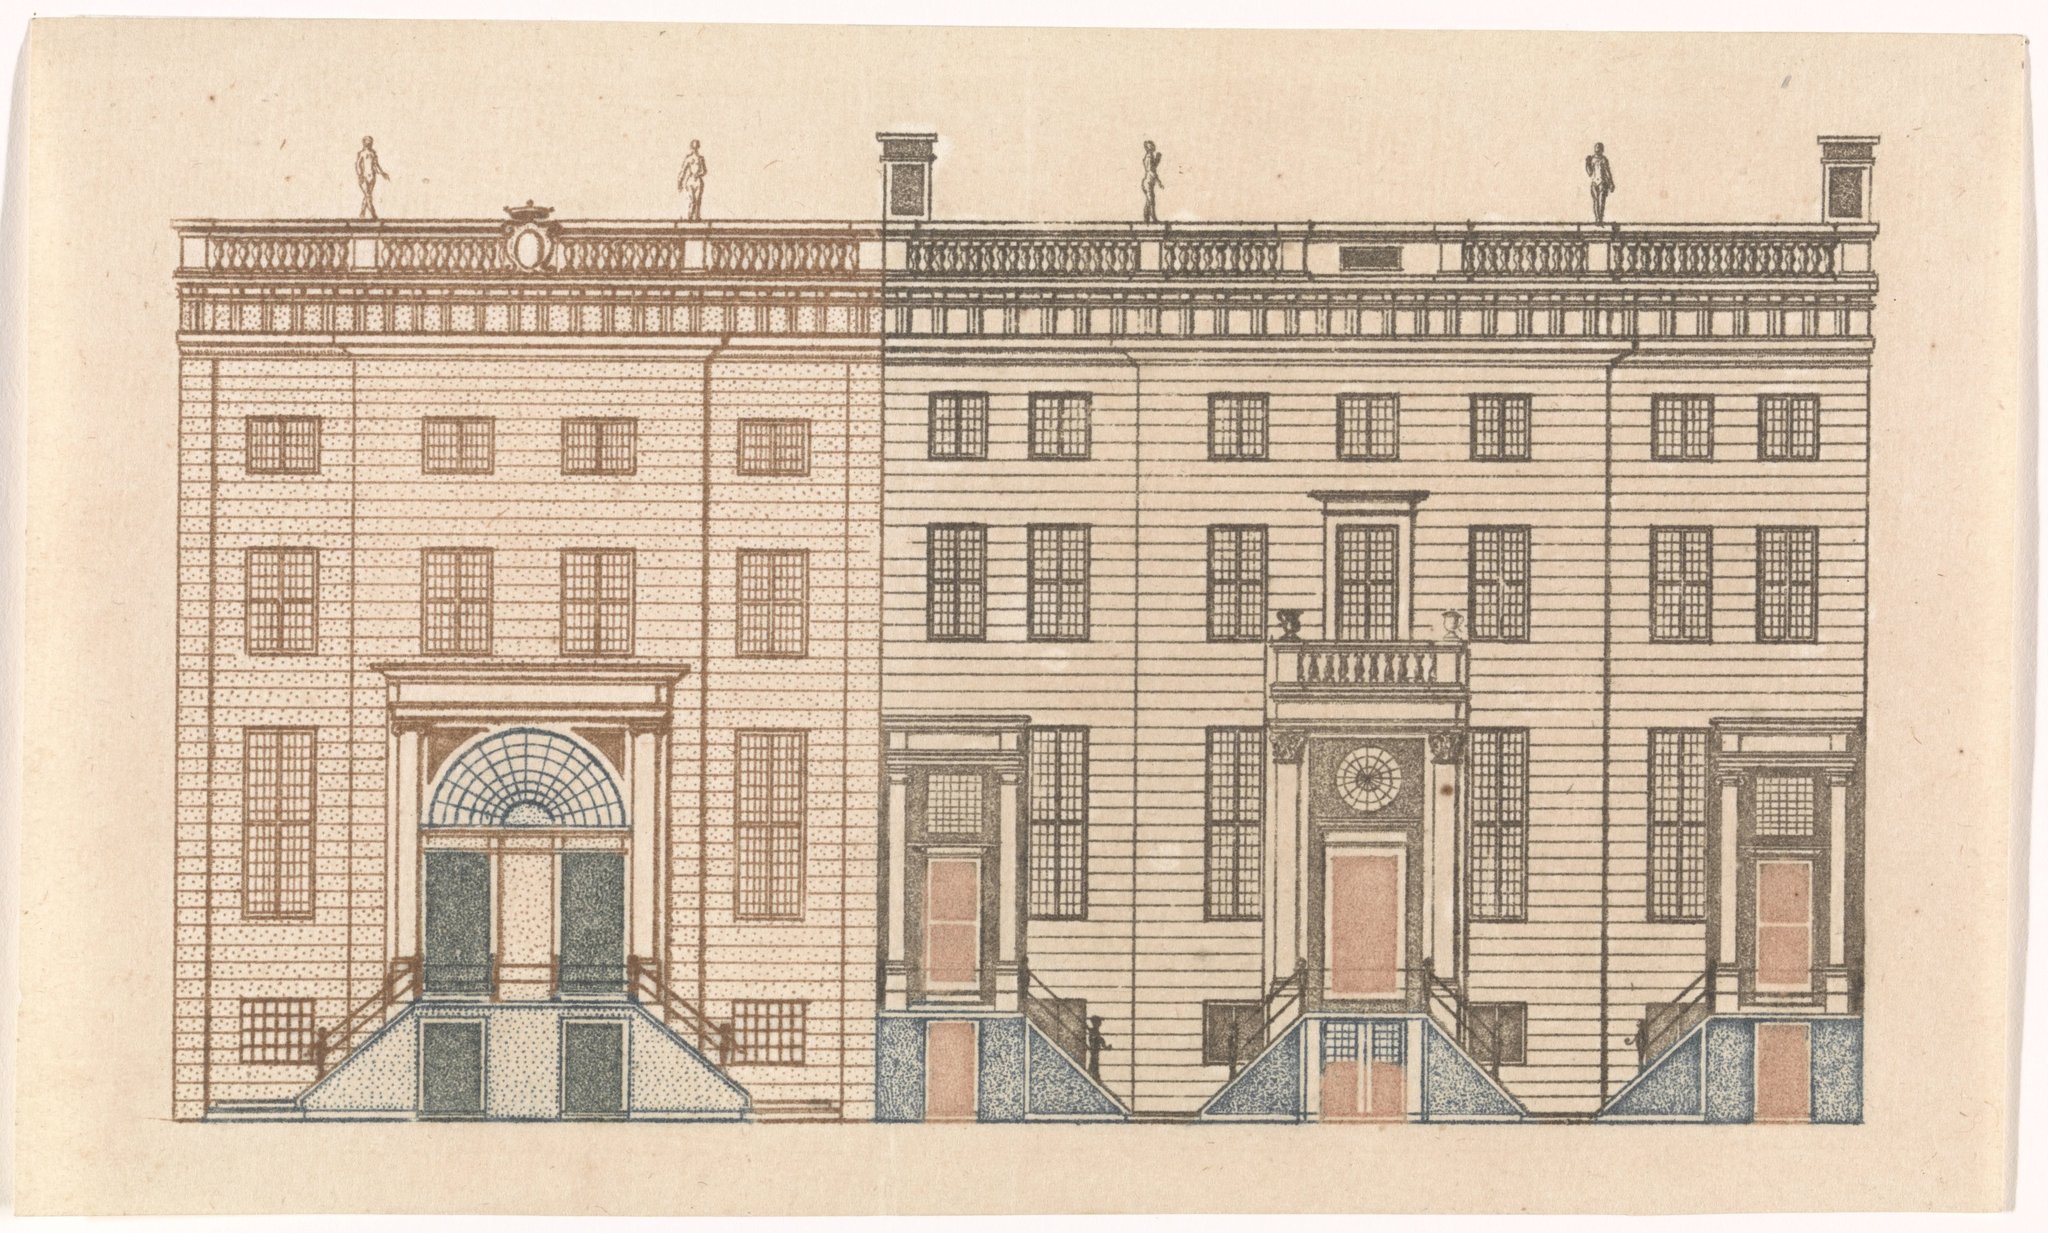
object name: print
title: Amsterdamse grachtenhuizen aan de Keizersgracht 738-730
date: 1696-1706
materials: paper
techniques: etching, lithography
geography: amsterdam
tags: the usual house or row of houses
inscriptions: collector's mark: Lugt 2228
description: Prent mogelijk gebruikt in: Het Stadhuys van Amsterdam beneffenis verscheyde van de grooste en nieuwste gebouwe. Nieuwelycks uytgegeven door Cornelis Danckerts voor aen op de Nieuwendyck inde Atlas tot Amsterdam met Previlegie. Amsterdam: Cornelis Danckerts, [1696-1706].